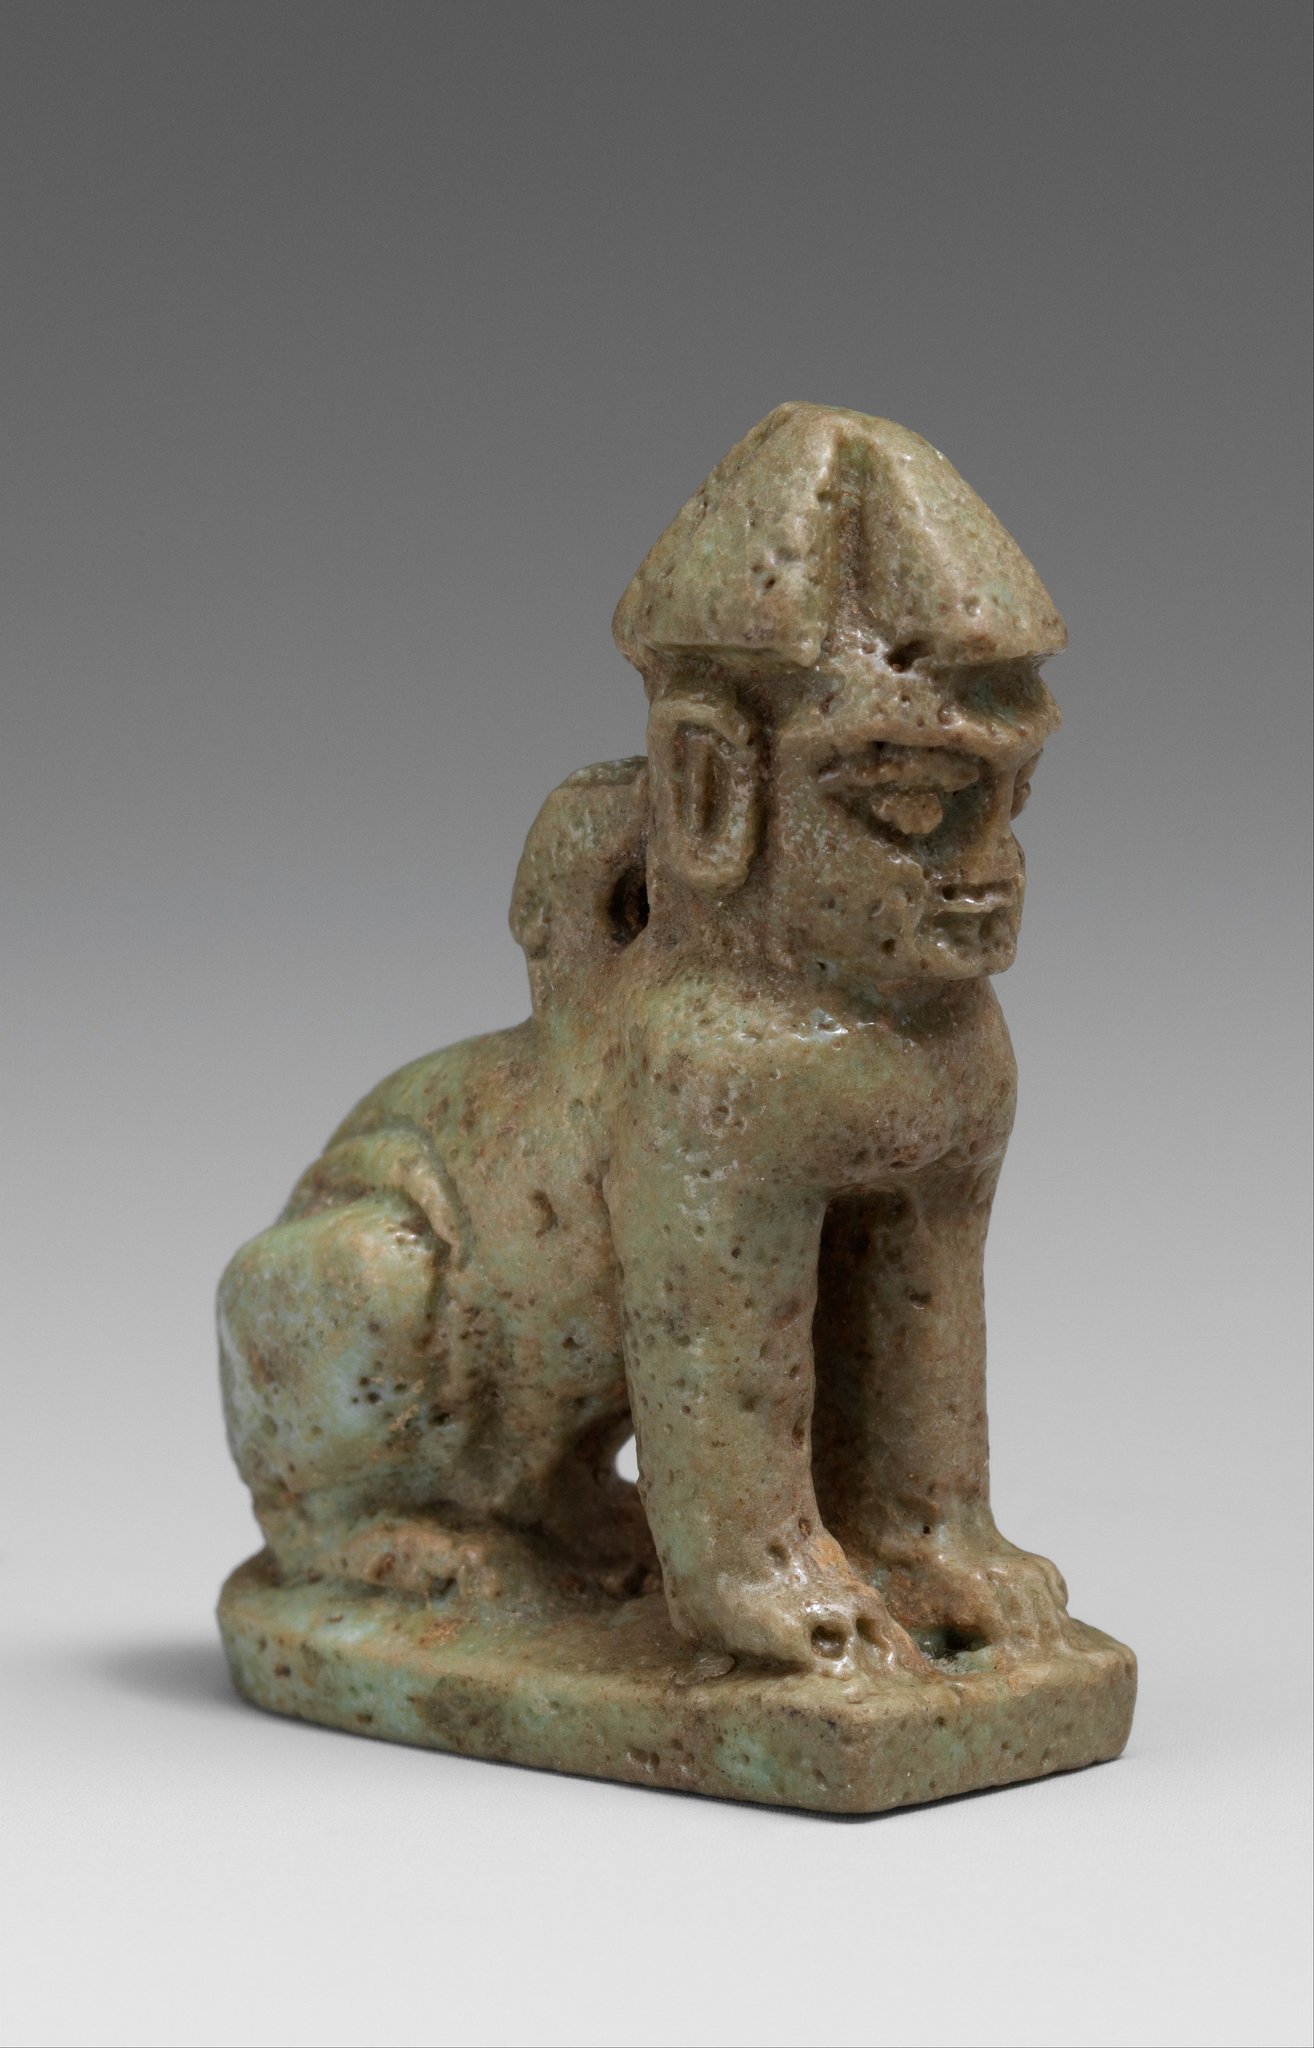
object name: amulet, human headed cat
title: Human-headed cat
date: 945-525 BCE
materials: faience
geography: egypt